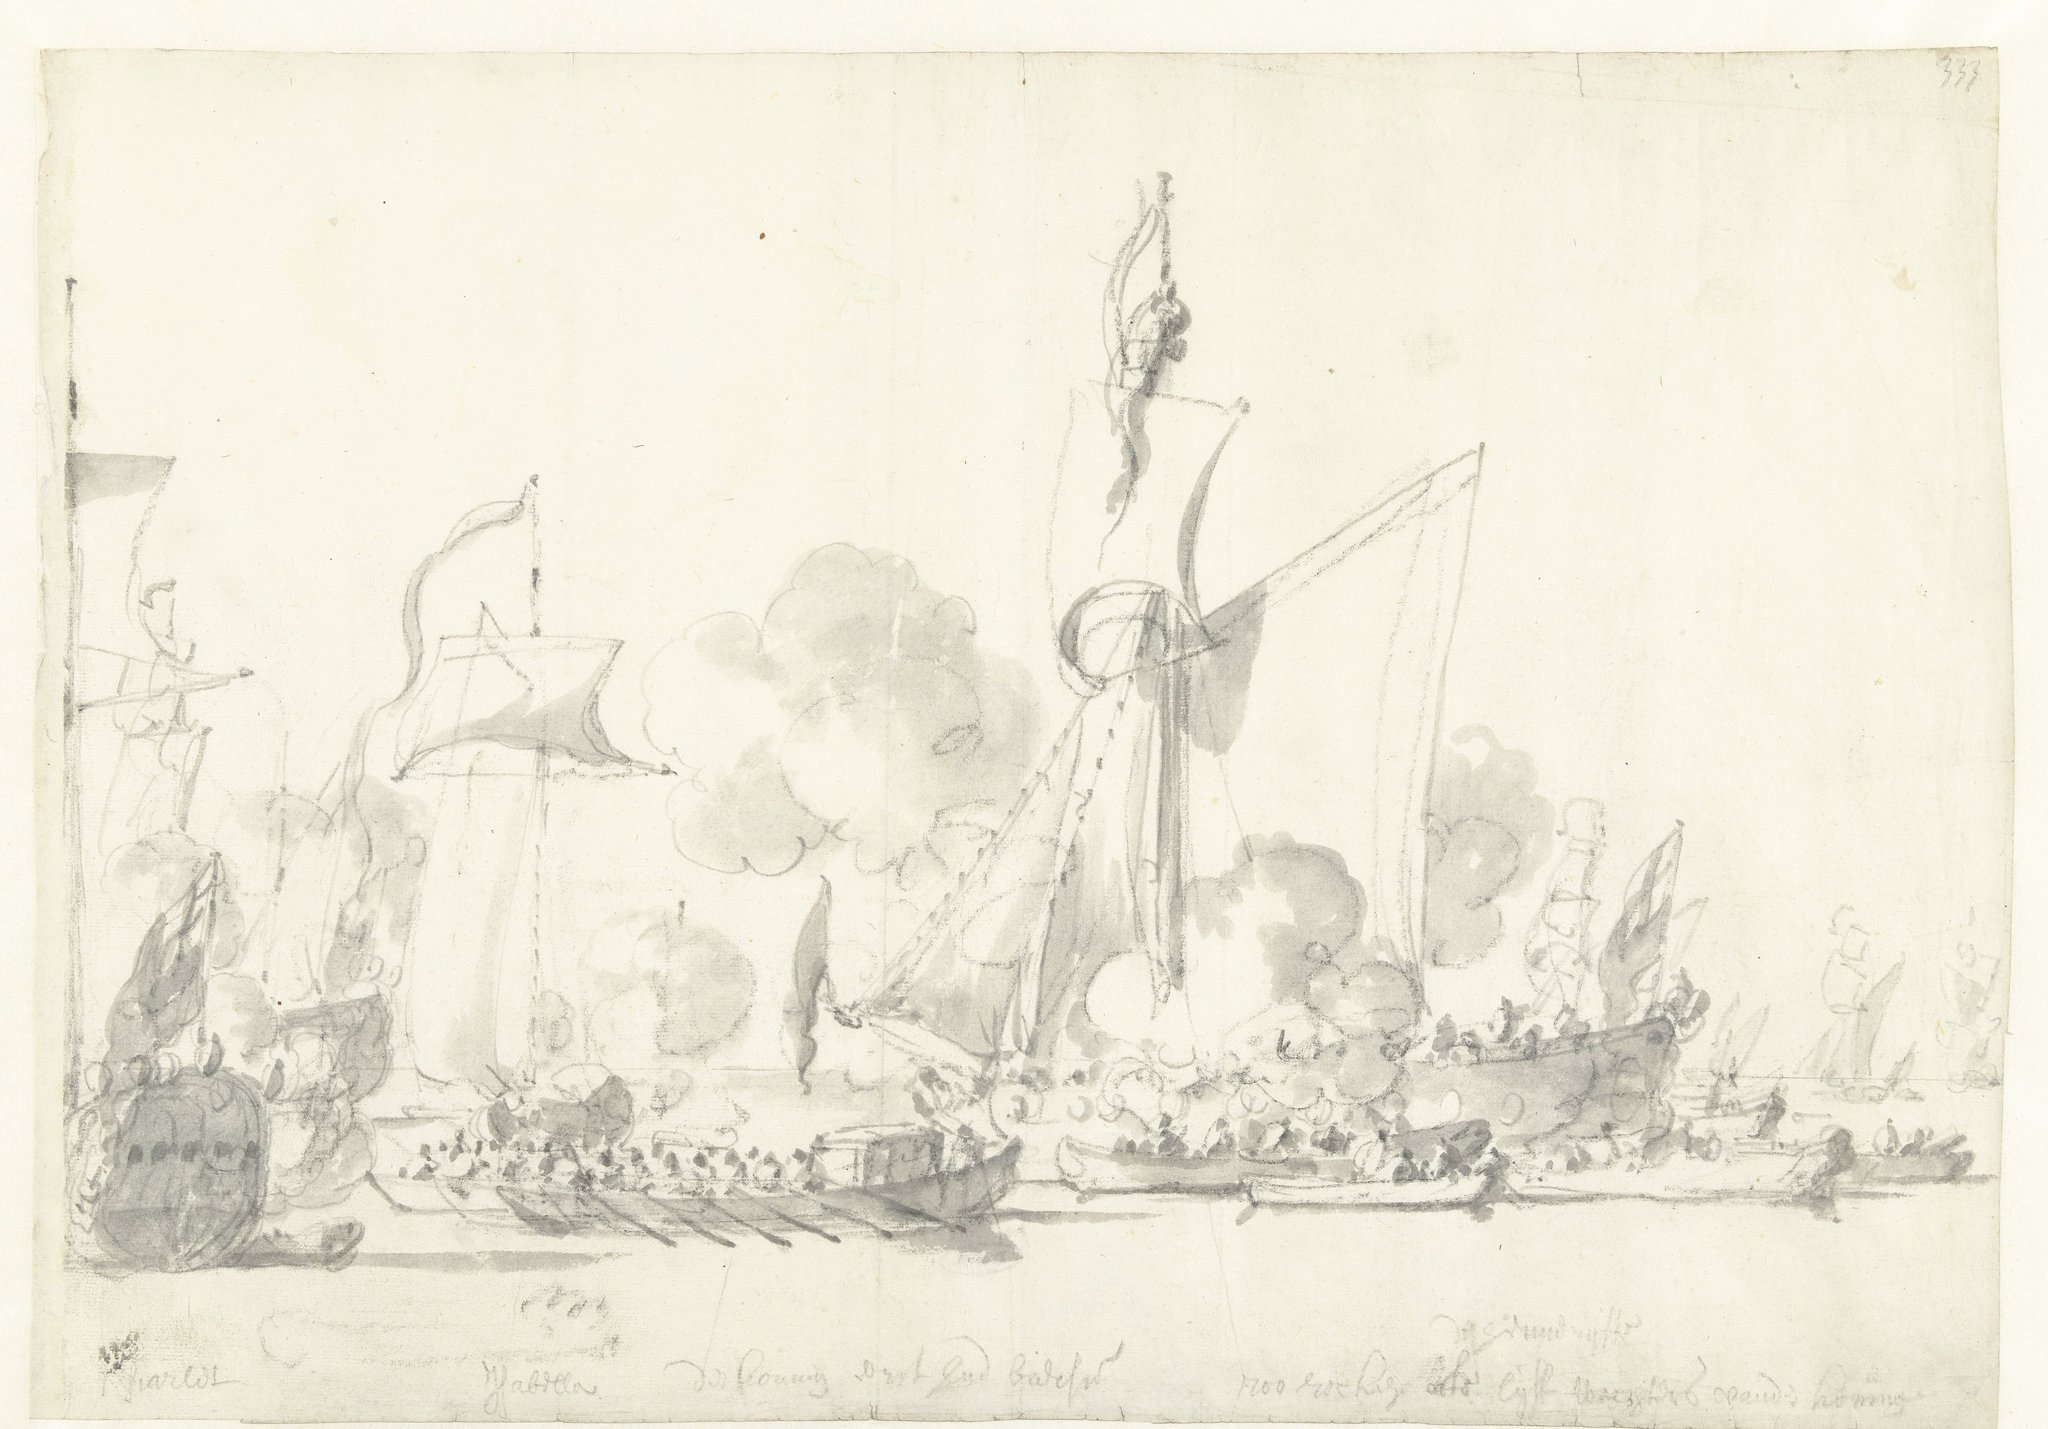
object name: drawing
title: De tocht van de Engelse koning Karel II over de Thames naar Sheerness en Chatham op 27 Augustus 1681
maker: willem van de velde (i)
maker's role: draughtsman, painter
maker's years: 1611-1693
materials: chalk, paper, pencil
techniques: brush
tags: london, karel ii (koning van engeland), names of artefacts and man-made objects (buildings excluded), river, visiting; receiving guests; elegant company, sailing-ship, sailing-boat (with name), thames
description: De tocht van de Engelse koning Karel II over de Thames naar Sheerness en Chatham op 27 augustus 1681. De koning verlaat het jacht Henrietta; links de Charlotte, rechts een sloep met lijfwachten van de koning.